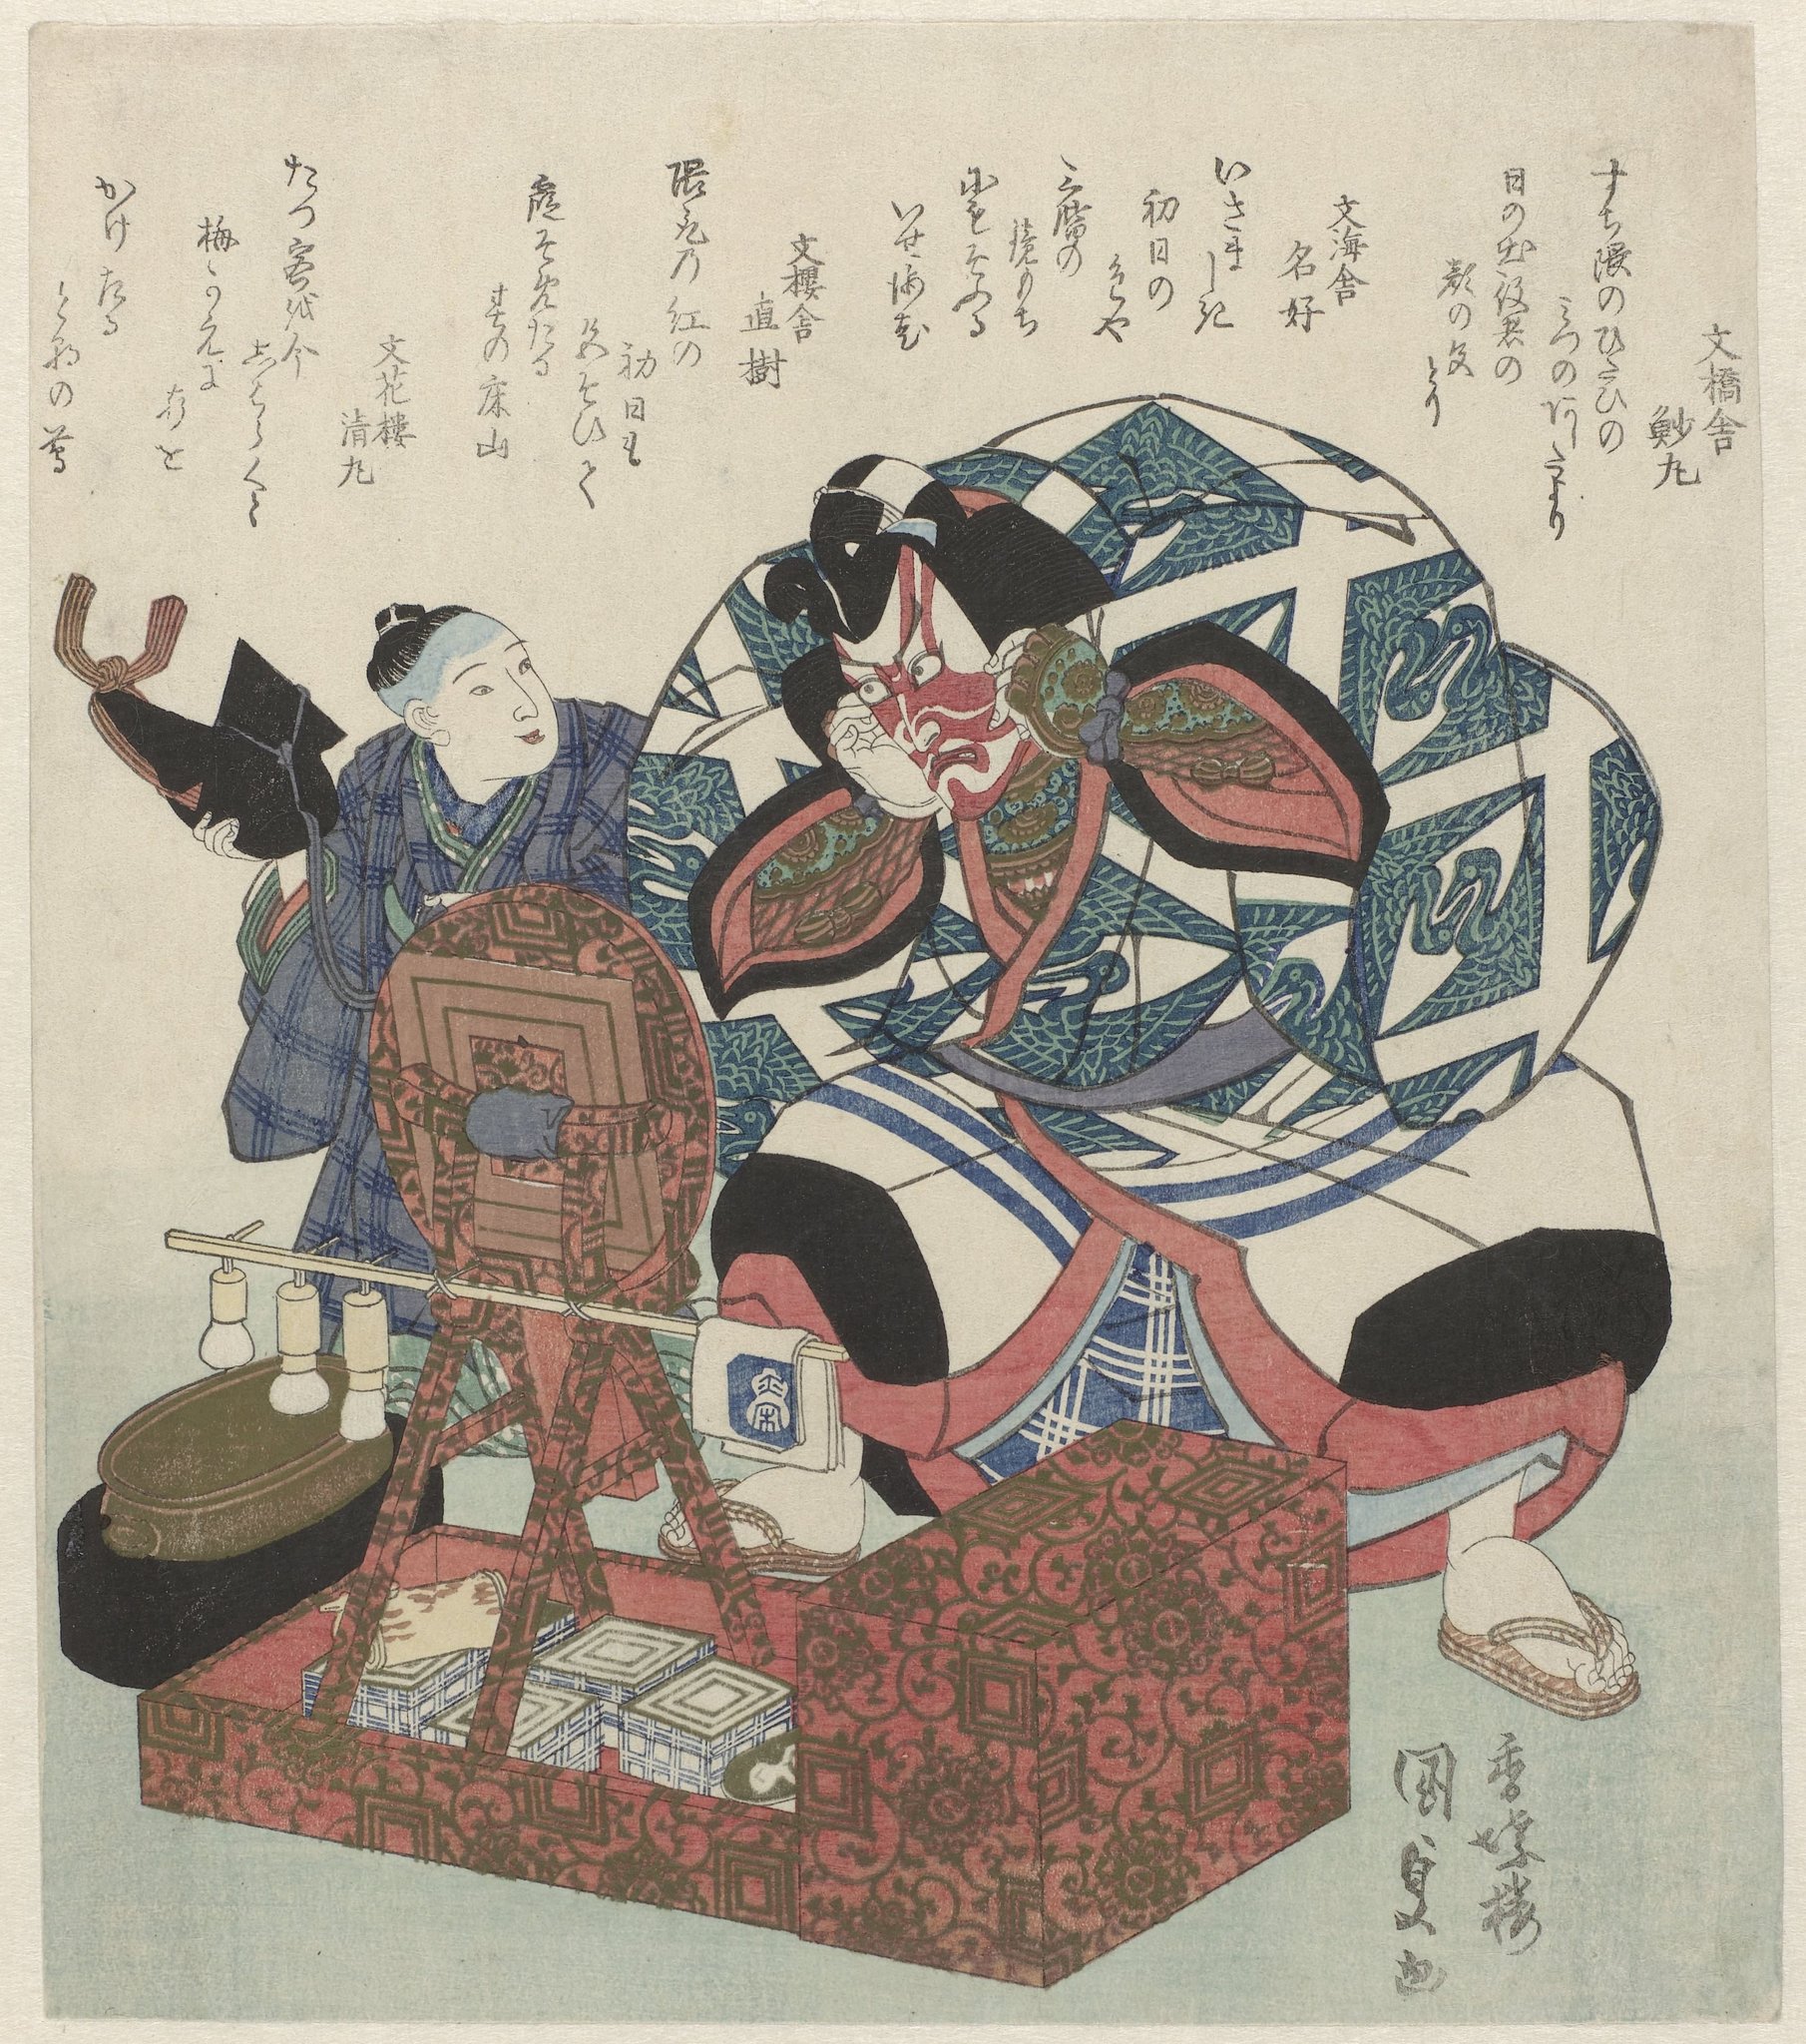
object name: print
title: De acteur Ichikawa Danjuro VII maakt zich op voor een Shibaraku voorstelling geassisteerd door een jongen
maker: utagawa kunisada (i)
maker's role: print maker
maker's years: 1786-1865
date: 1830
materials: paper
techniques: woodcut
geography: edo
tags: mask, looking in the mirror; contemplation of own beauty, actor (on the stage)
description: Een surimono is een luxe uitgevoerde prent waarop beeld met één of meerdere gedichten gecombineerd is. Bij het drukken van een surimono werd vaak gebruik gemaakt van dikker papier, blinddruk en metaal pigmenten, zoals koper- en zilverpoeder. De prenten werden vaak in opdracht van dichters gemaakt en als exclusief geschenk aan vrienden en relaties gegeven.